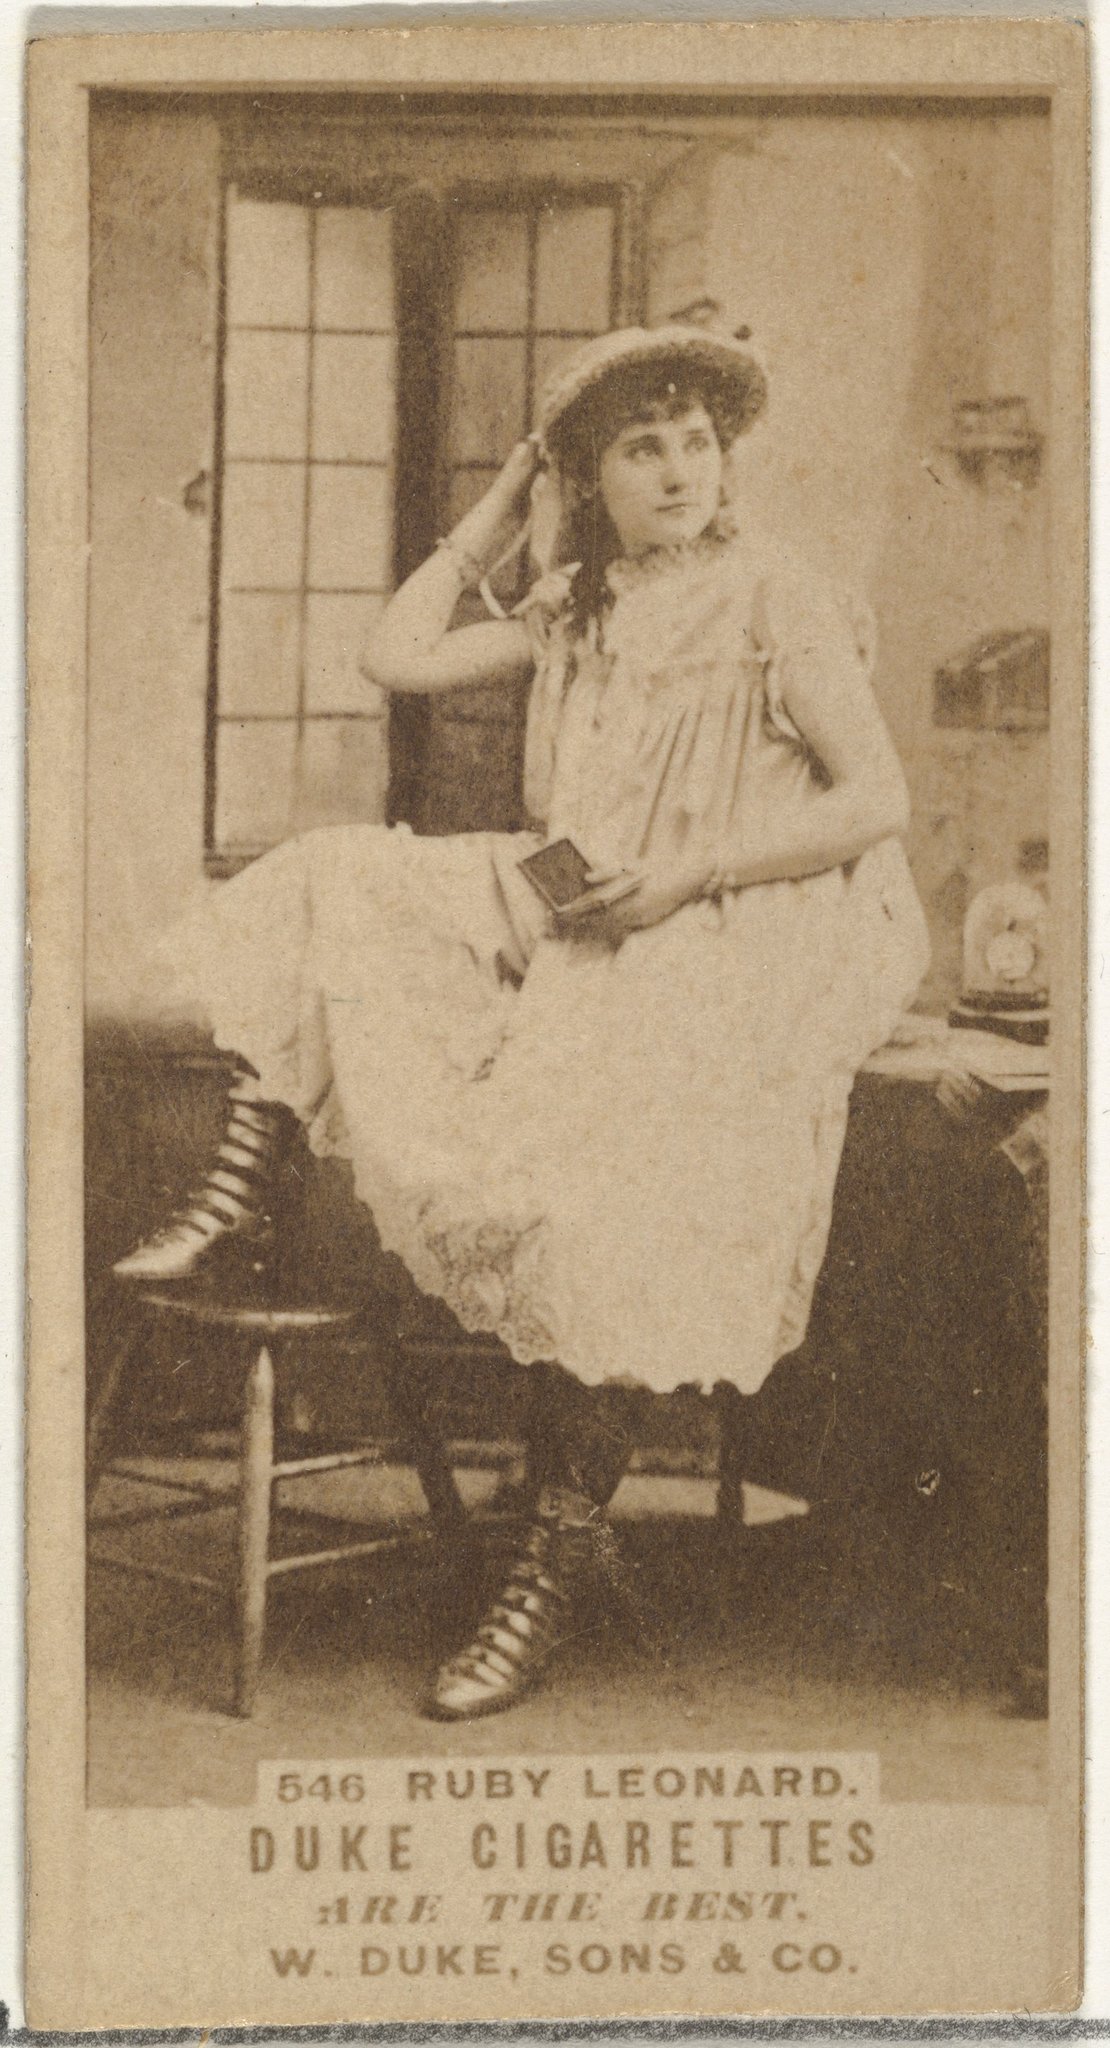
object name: photograph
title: Card Number 546, Ruby Leonard, from the Actors and Actresses series (N145-7) issued by Duke Sons & Co. to promote Duke Cigarettes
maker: w. duke, sons & co.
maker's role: publisher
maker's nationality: american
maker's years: 1870-1920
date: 1880-1889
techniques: albumen silver print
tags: portraits,women,actresses